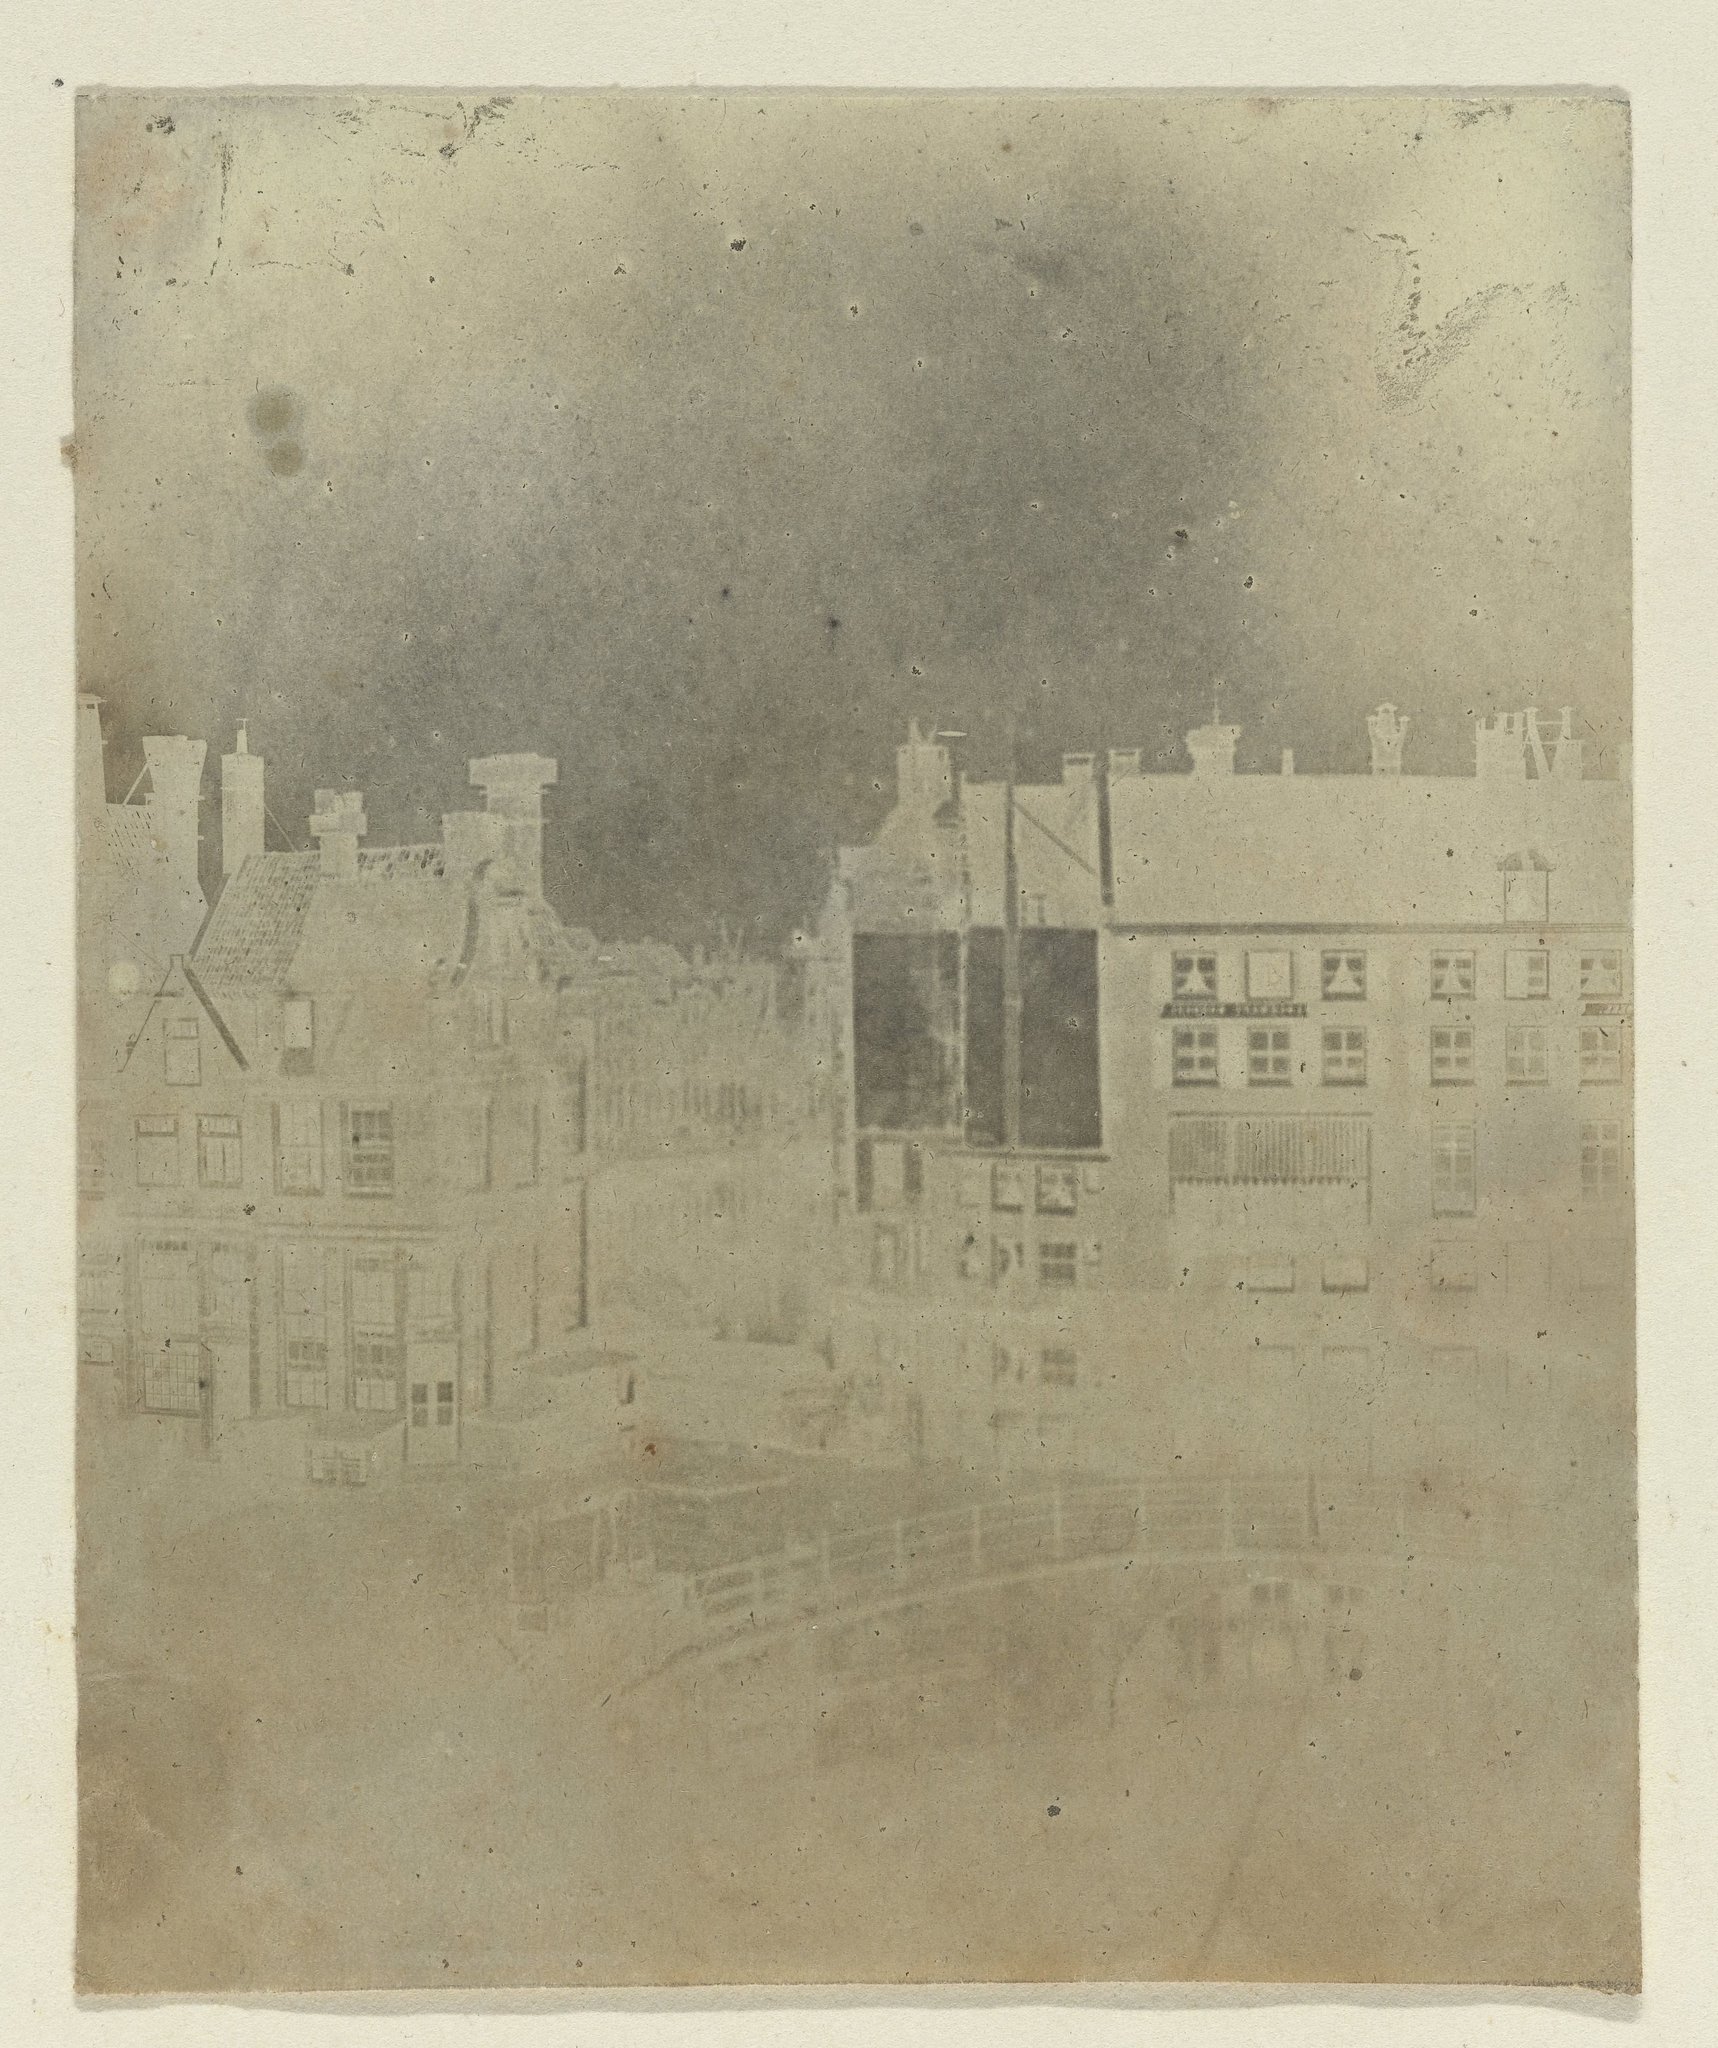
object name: papiernegatief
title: Gezicht vanuit het huis van de fotograaf richting logement Rondeel, Amsterdam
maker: eduard isaac asser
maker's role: amateurfotograaf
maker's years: 1809-1894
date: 1845-1846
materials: paper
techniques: paper negative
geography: amsterdam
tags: hotel het rondeel, reguliersbreestraat, kloveniersburgwal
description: Uitzicht uit het huis van de fotograaf, Singel 548, naar Logement Rondeel. De opname is gemaakt na de renovatie van het hotel in 1845.